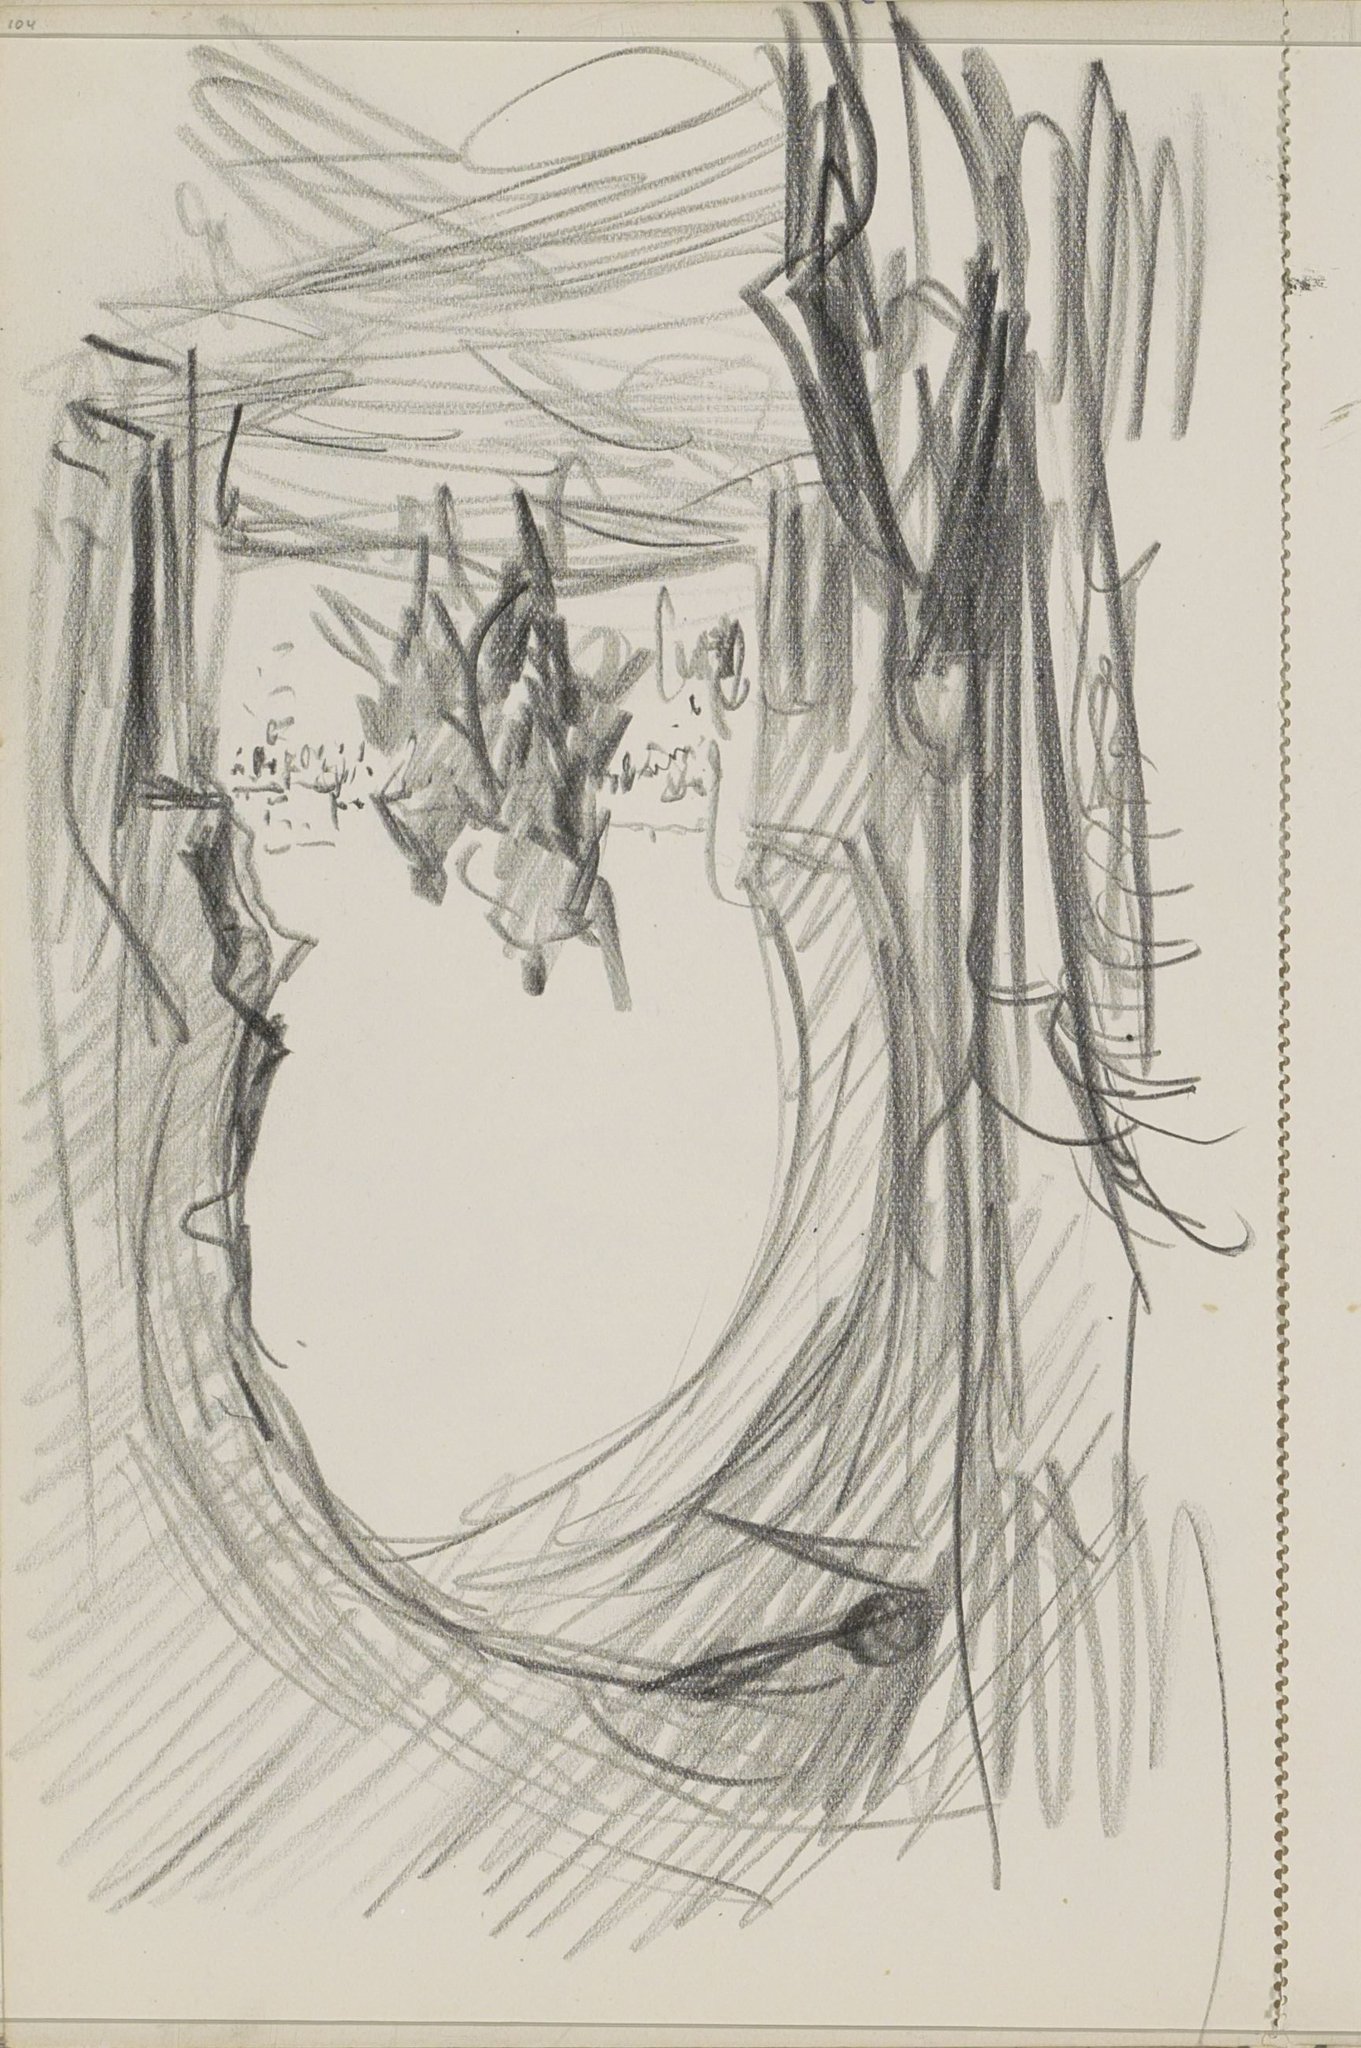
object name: sketchbook leaf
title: Ruiters bij een poort, vermoedelijk de Bab Mansour poort in Meknès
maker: marius bauer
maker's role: draughtsman, print maker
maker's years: 1867-1932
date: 1923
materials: paper, pencil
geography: morocco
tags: riding a horse, ass, or mule; rider, horseman, gate, entrance, street (+ city(-scape) with figures, staffage)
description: Pagina 104 uit een schetsboek met 66 bladen.